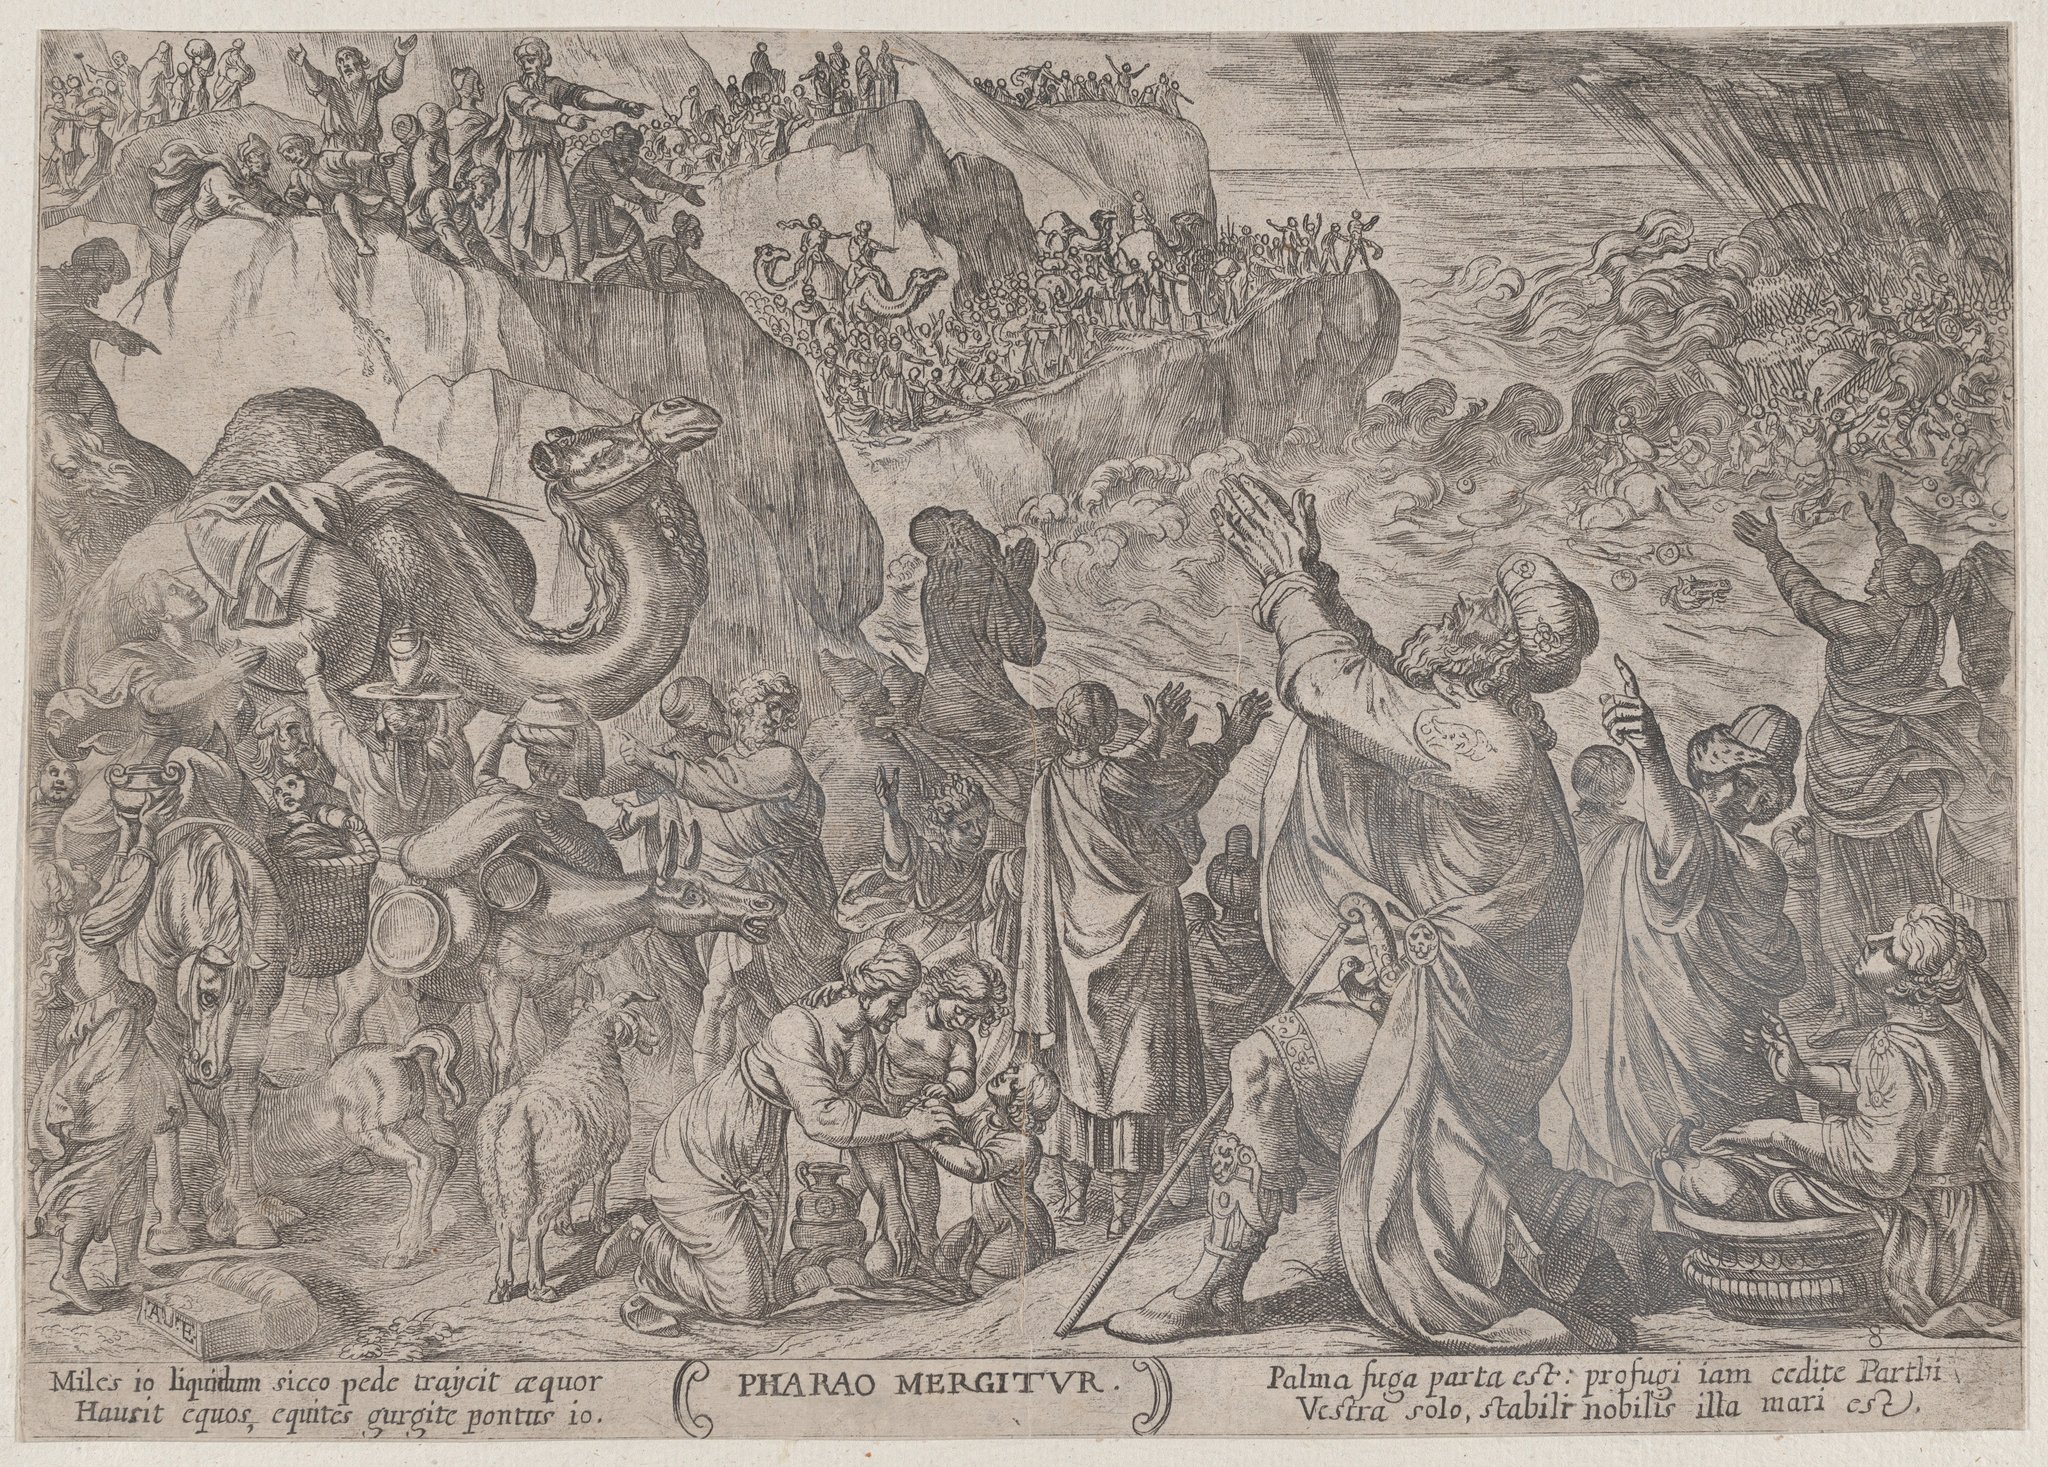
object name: print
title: Plate 8: The Egyptians Drowning in the Red Sea, from "The Battles of the Old Testament"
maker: antonio tempesta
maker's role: artist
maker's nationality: italian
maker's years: 1555-1630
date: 1590-1610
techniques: etching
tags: children,men,women,camels,horses